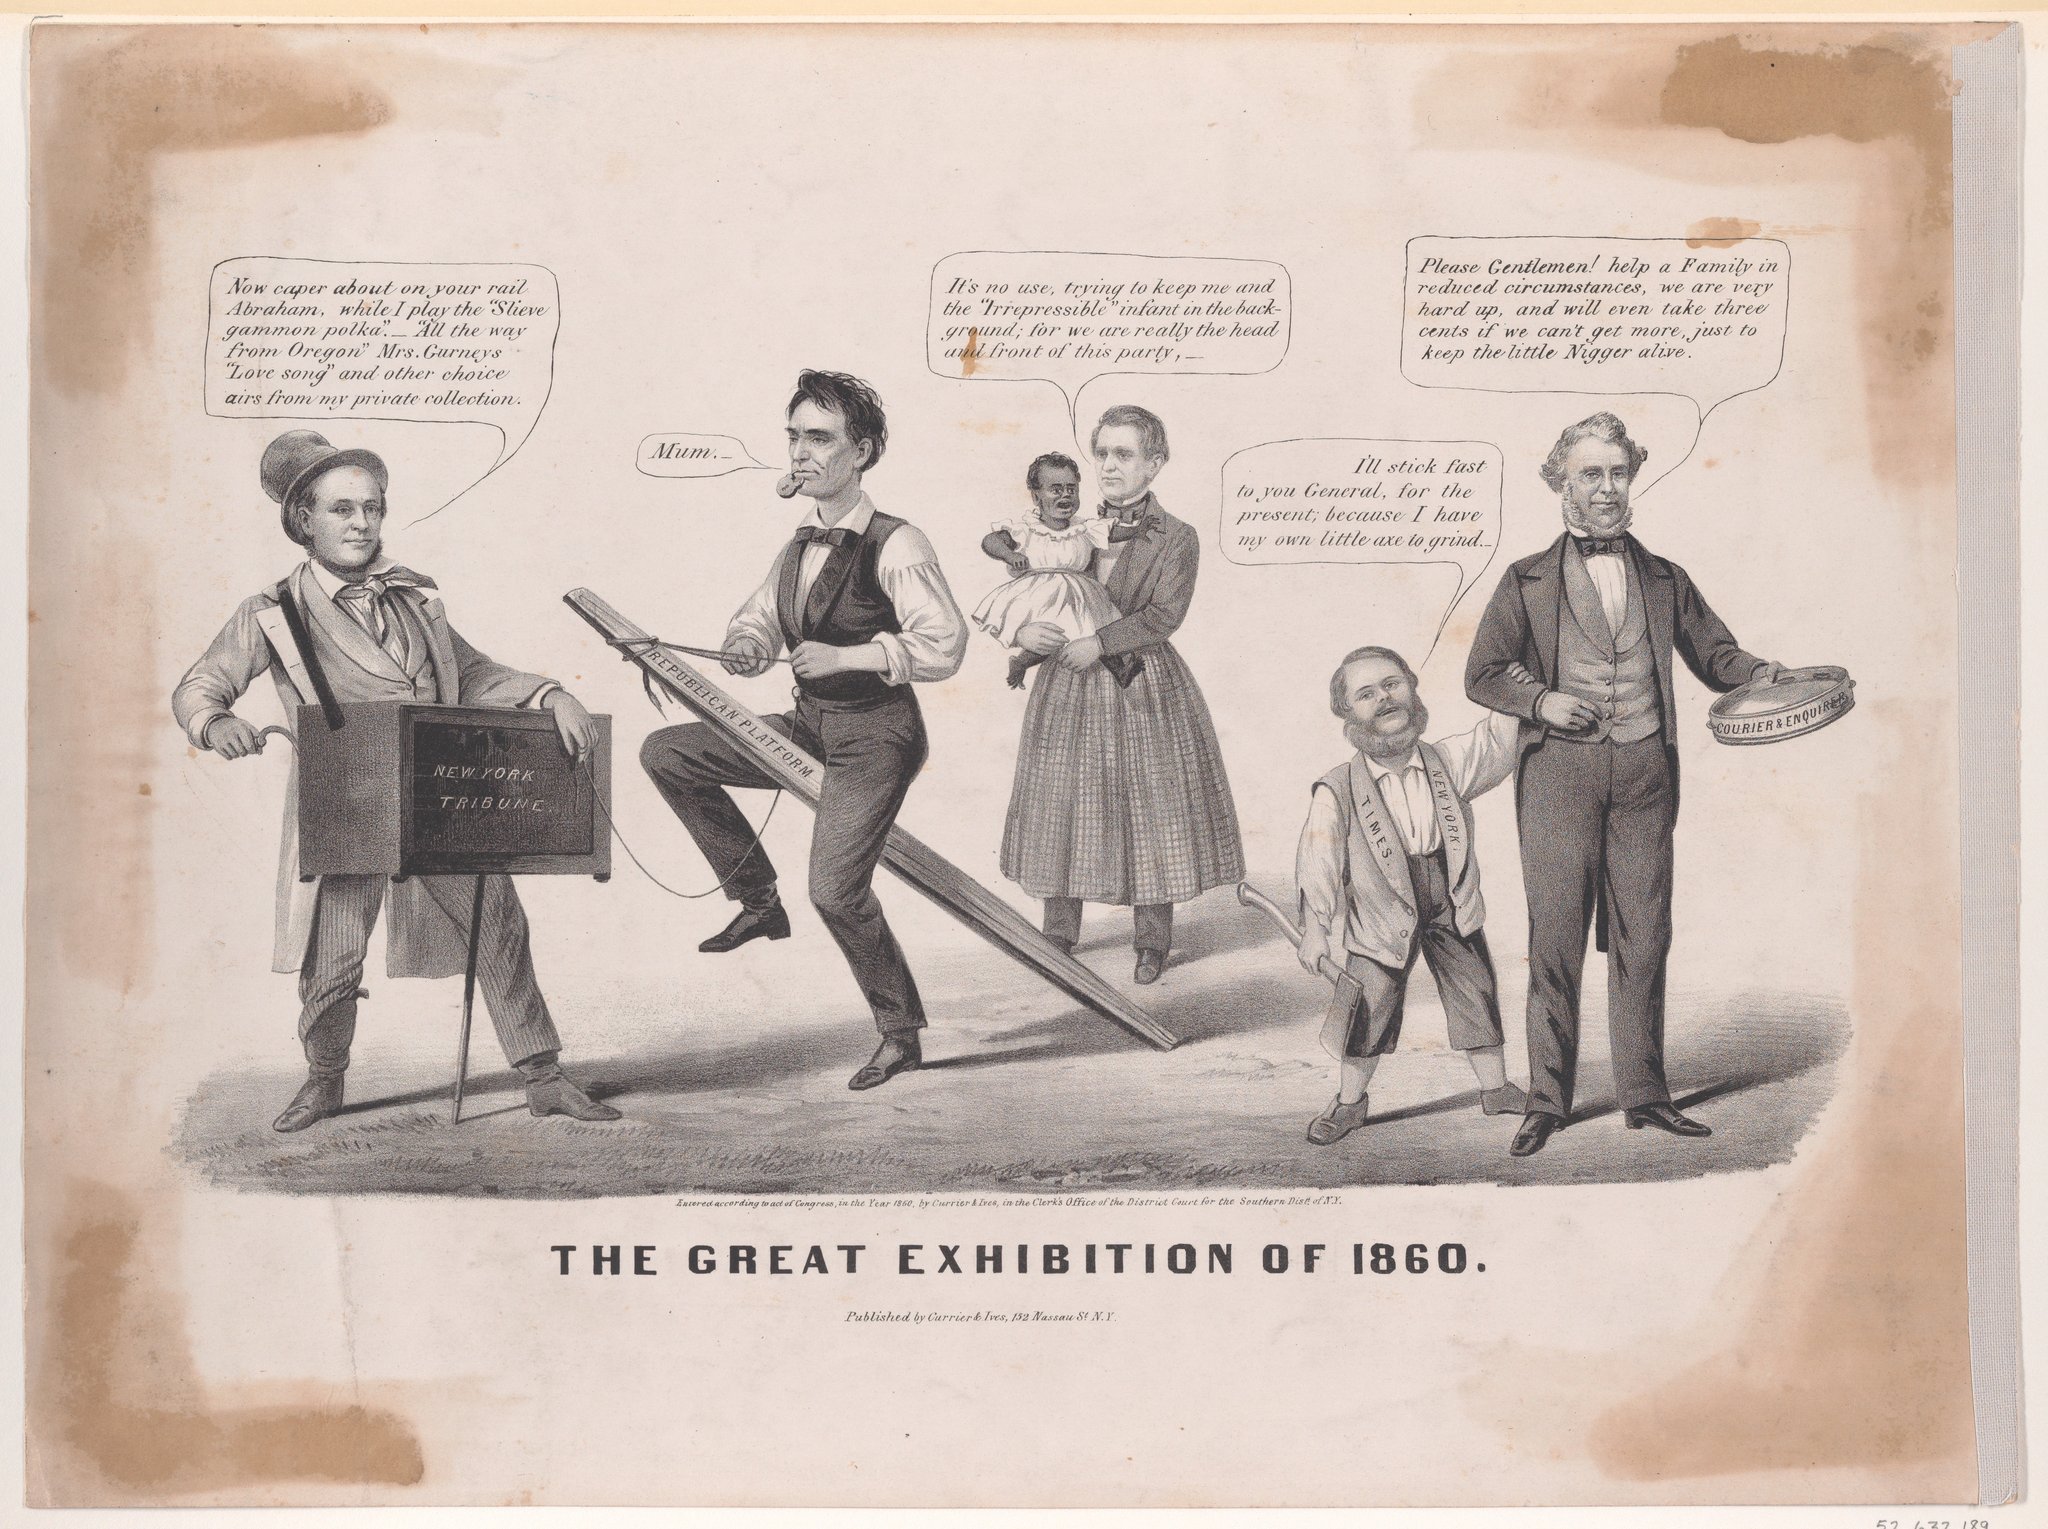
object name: print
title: The Great Exhibition of 1860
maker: louis maurer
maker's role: artist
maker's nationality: american, born germany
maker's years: 1832-1932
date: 1860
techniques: lithograph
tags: satire,abraham lincoln,infants,men,politics